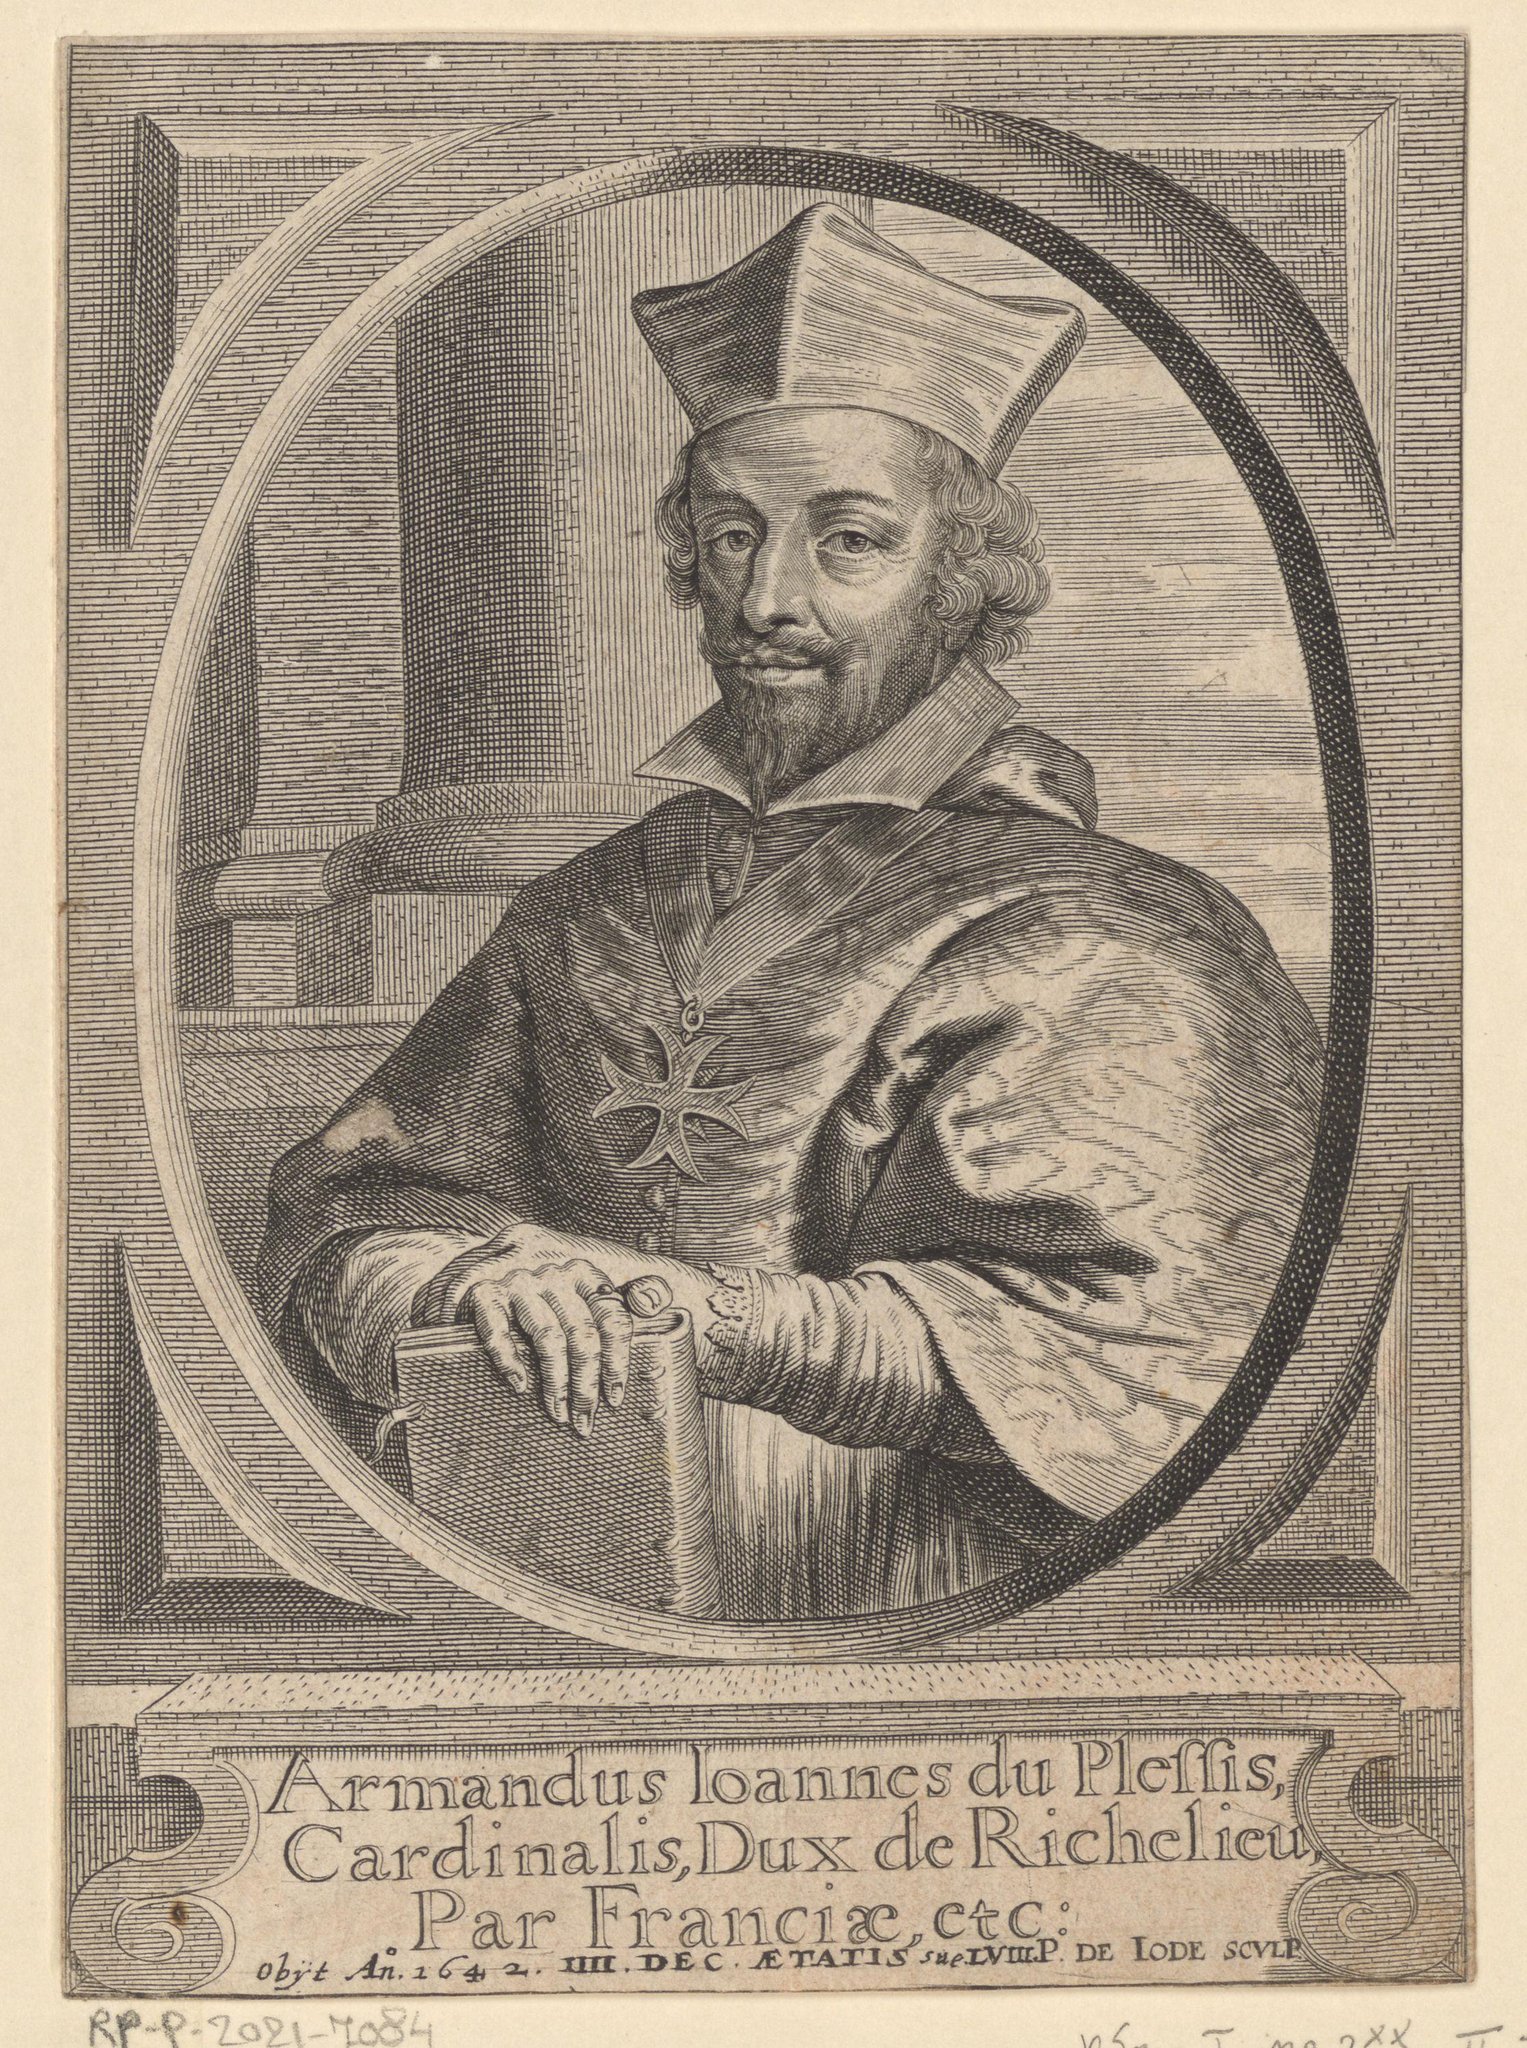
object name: print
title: Portret van Armand-Jean du Plessis hertog van Richelieu op 58-jarige leeftijd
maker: pieter de jode (ii)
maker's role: draughtsman, print maker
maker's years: 1606-1674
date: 1642-1670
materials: paper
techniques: engraving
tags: paris, armand-jean du plessis hertog van richelieu, cardinal, historical persons, book